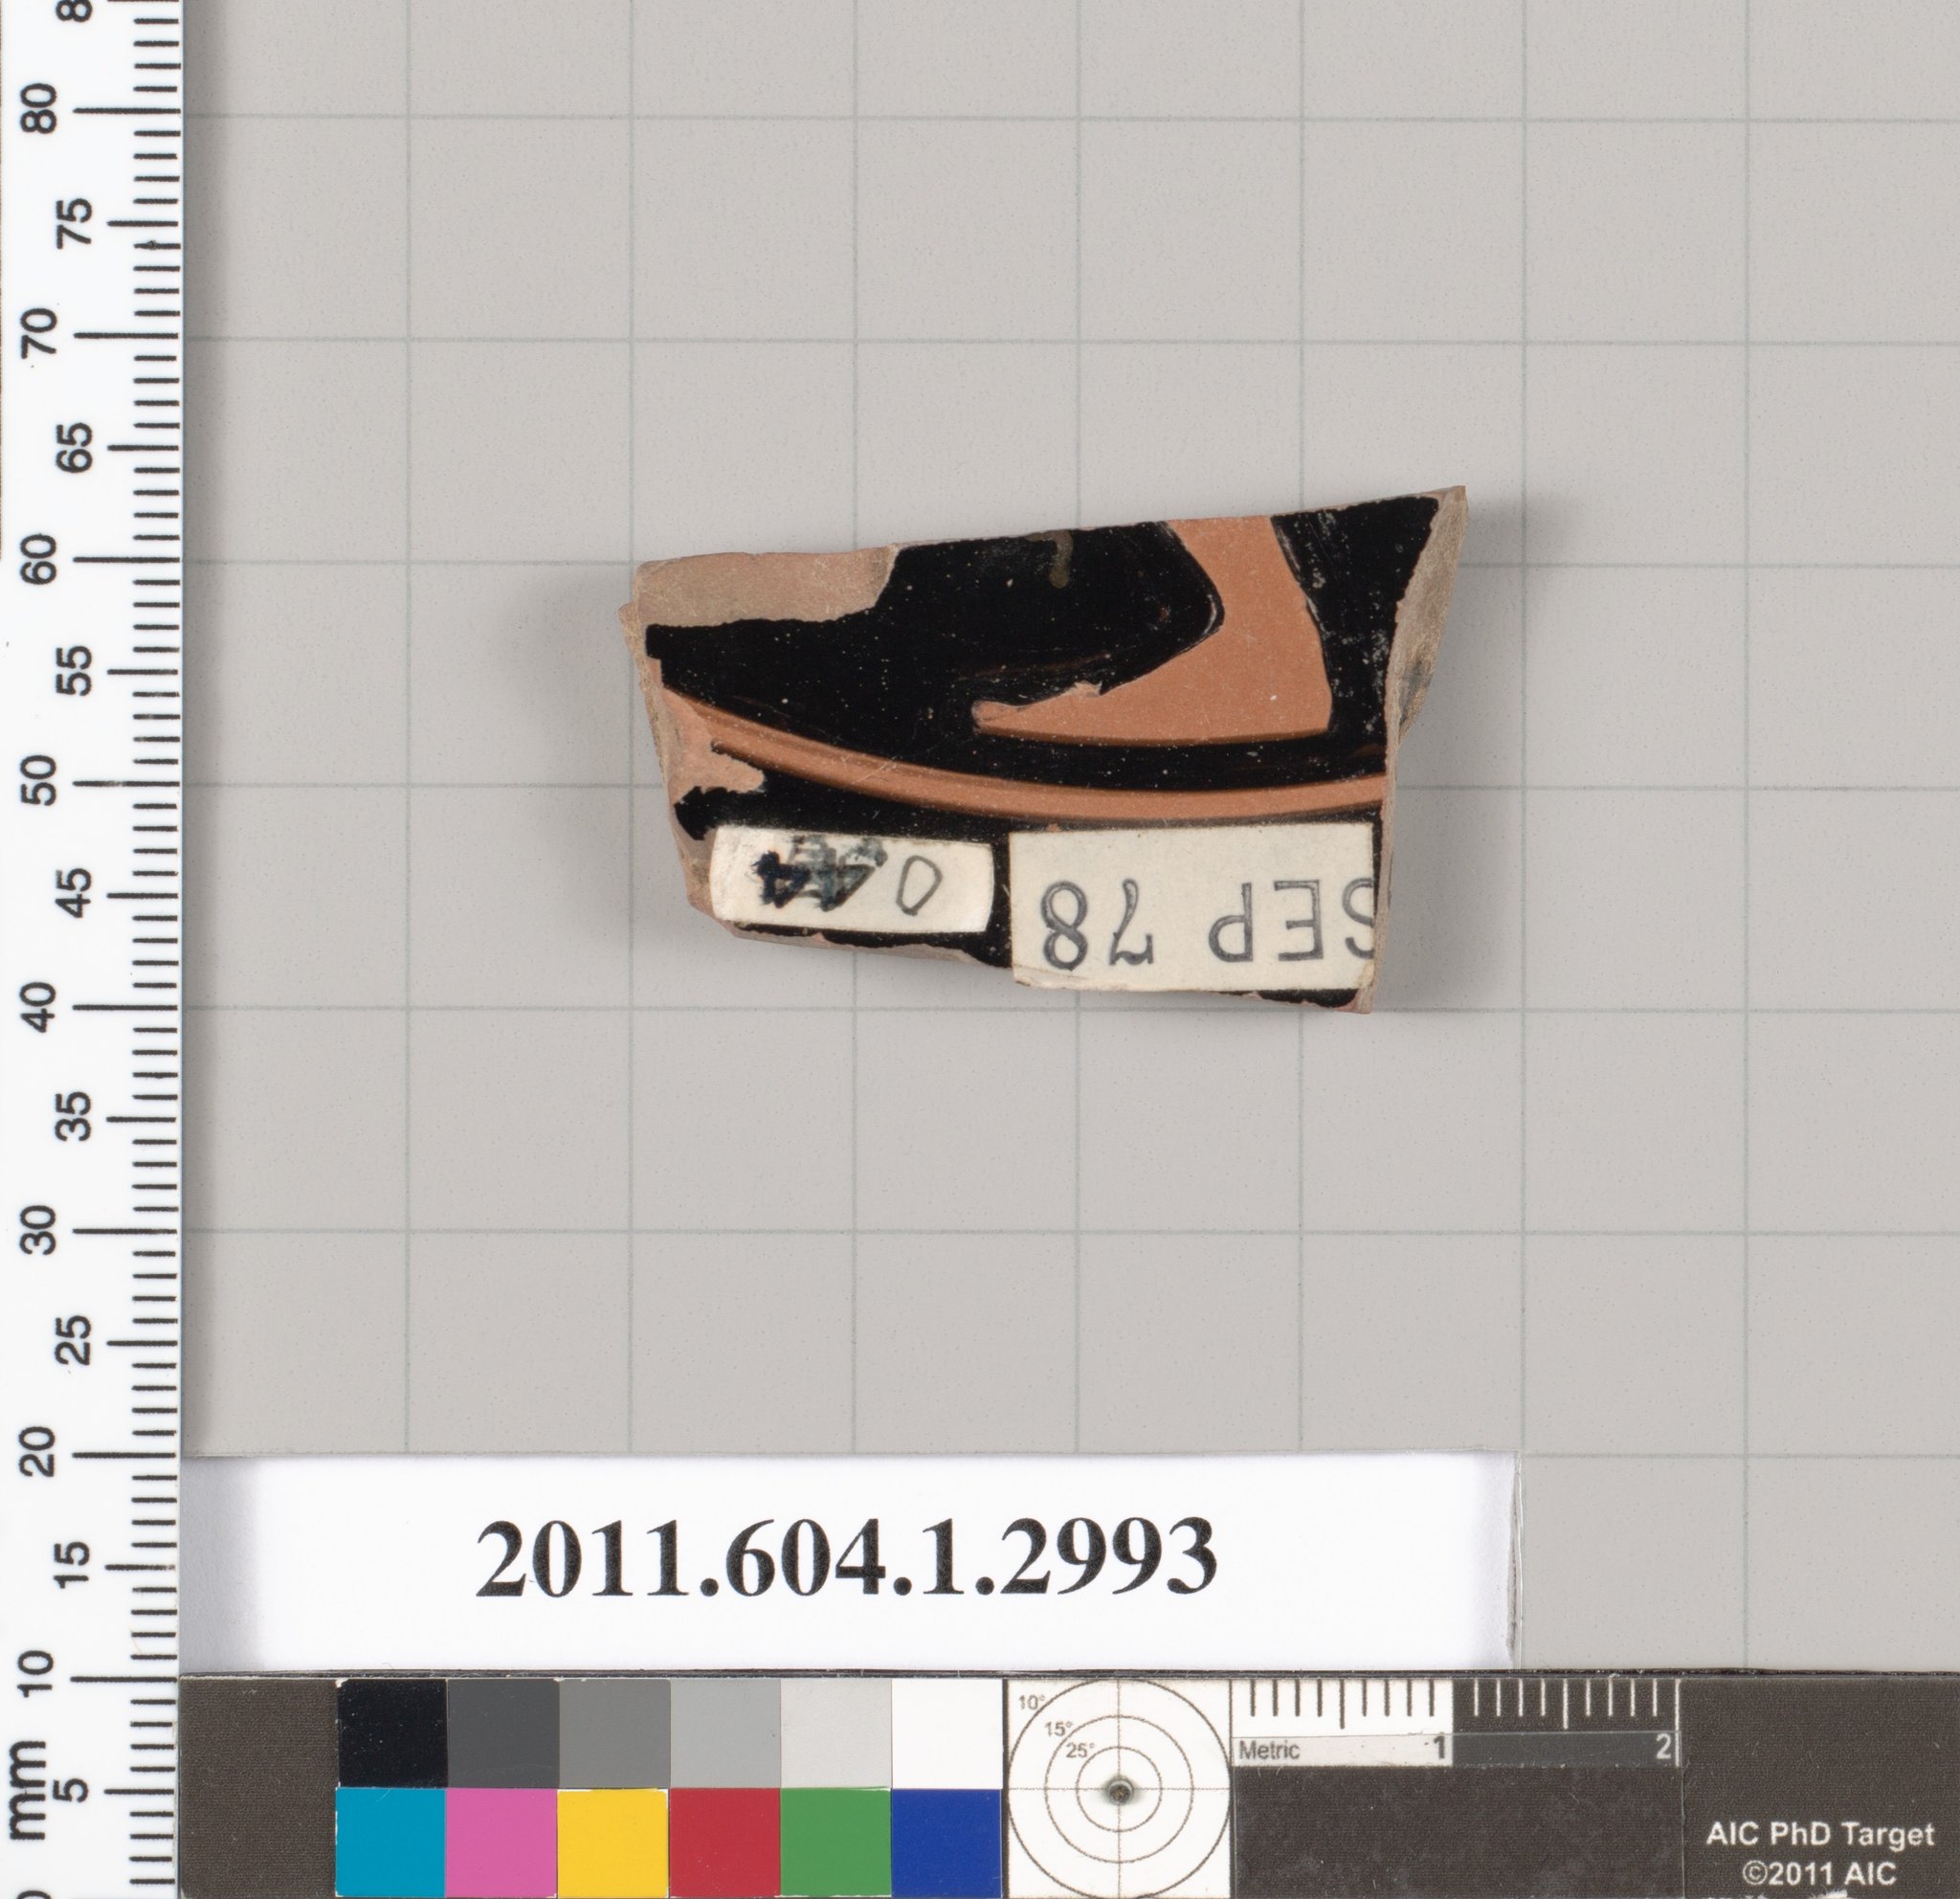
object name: kylix fragment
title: Terracotta fragment of a kylix (drinking cup)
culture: greek, attic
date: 520-500 BCE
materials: terracotta